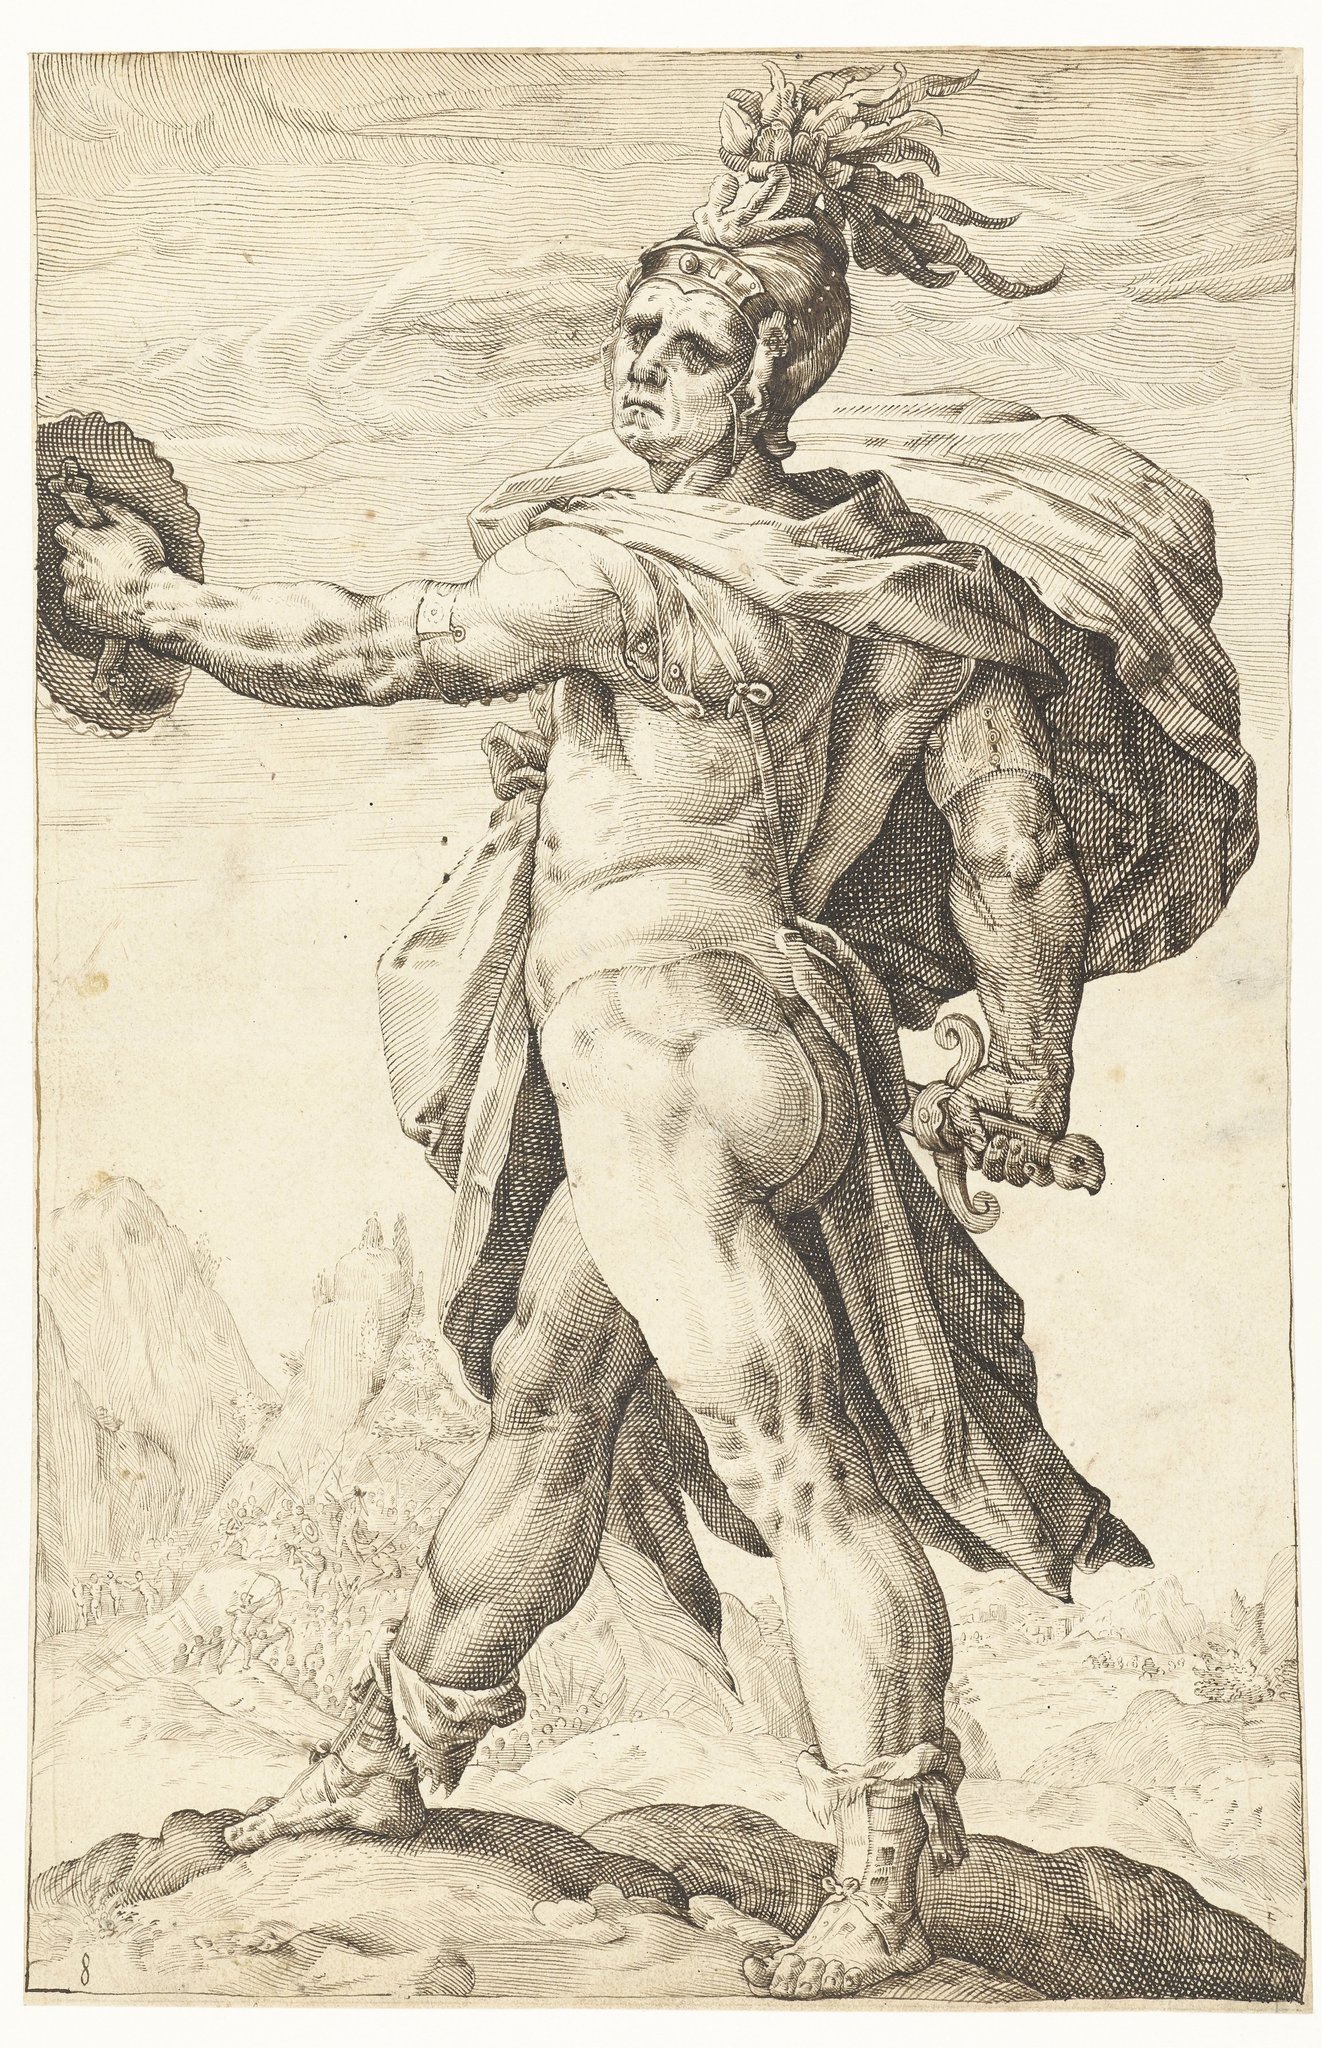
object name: drawing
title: Calpurnius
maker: lucas van haelwech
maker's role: draughtsman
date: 1602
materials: ink, paper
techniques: pen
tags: male persons from classical history (calpurnius, m.)